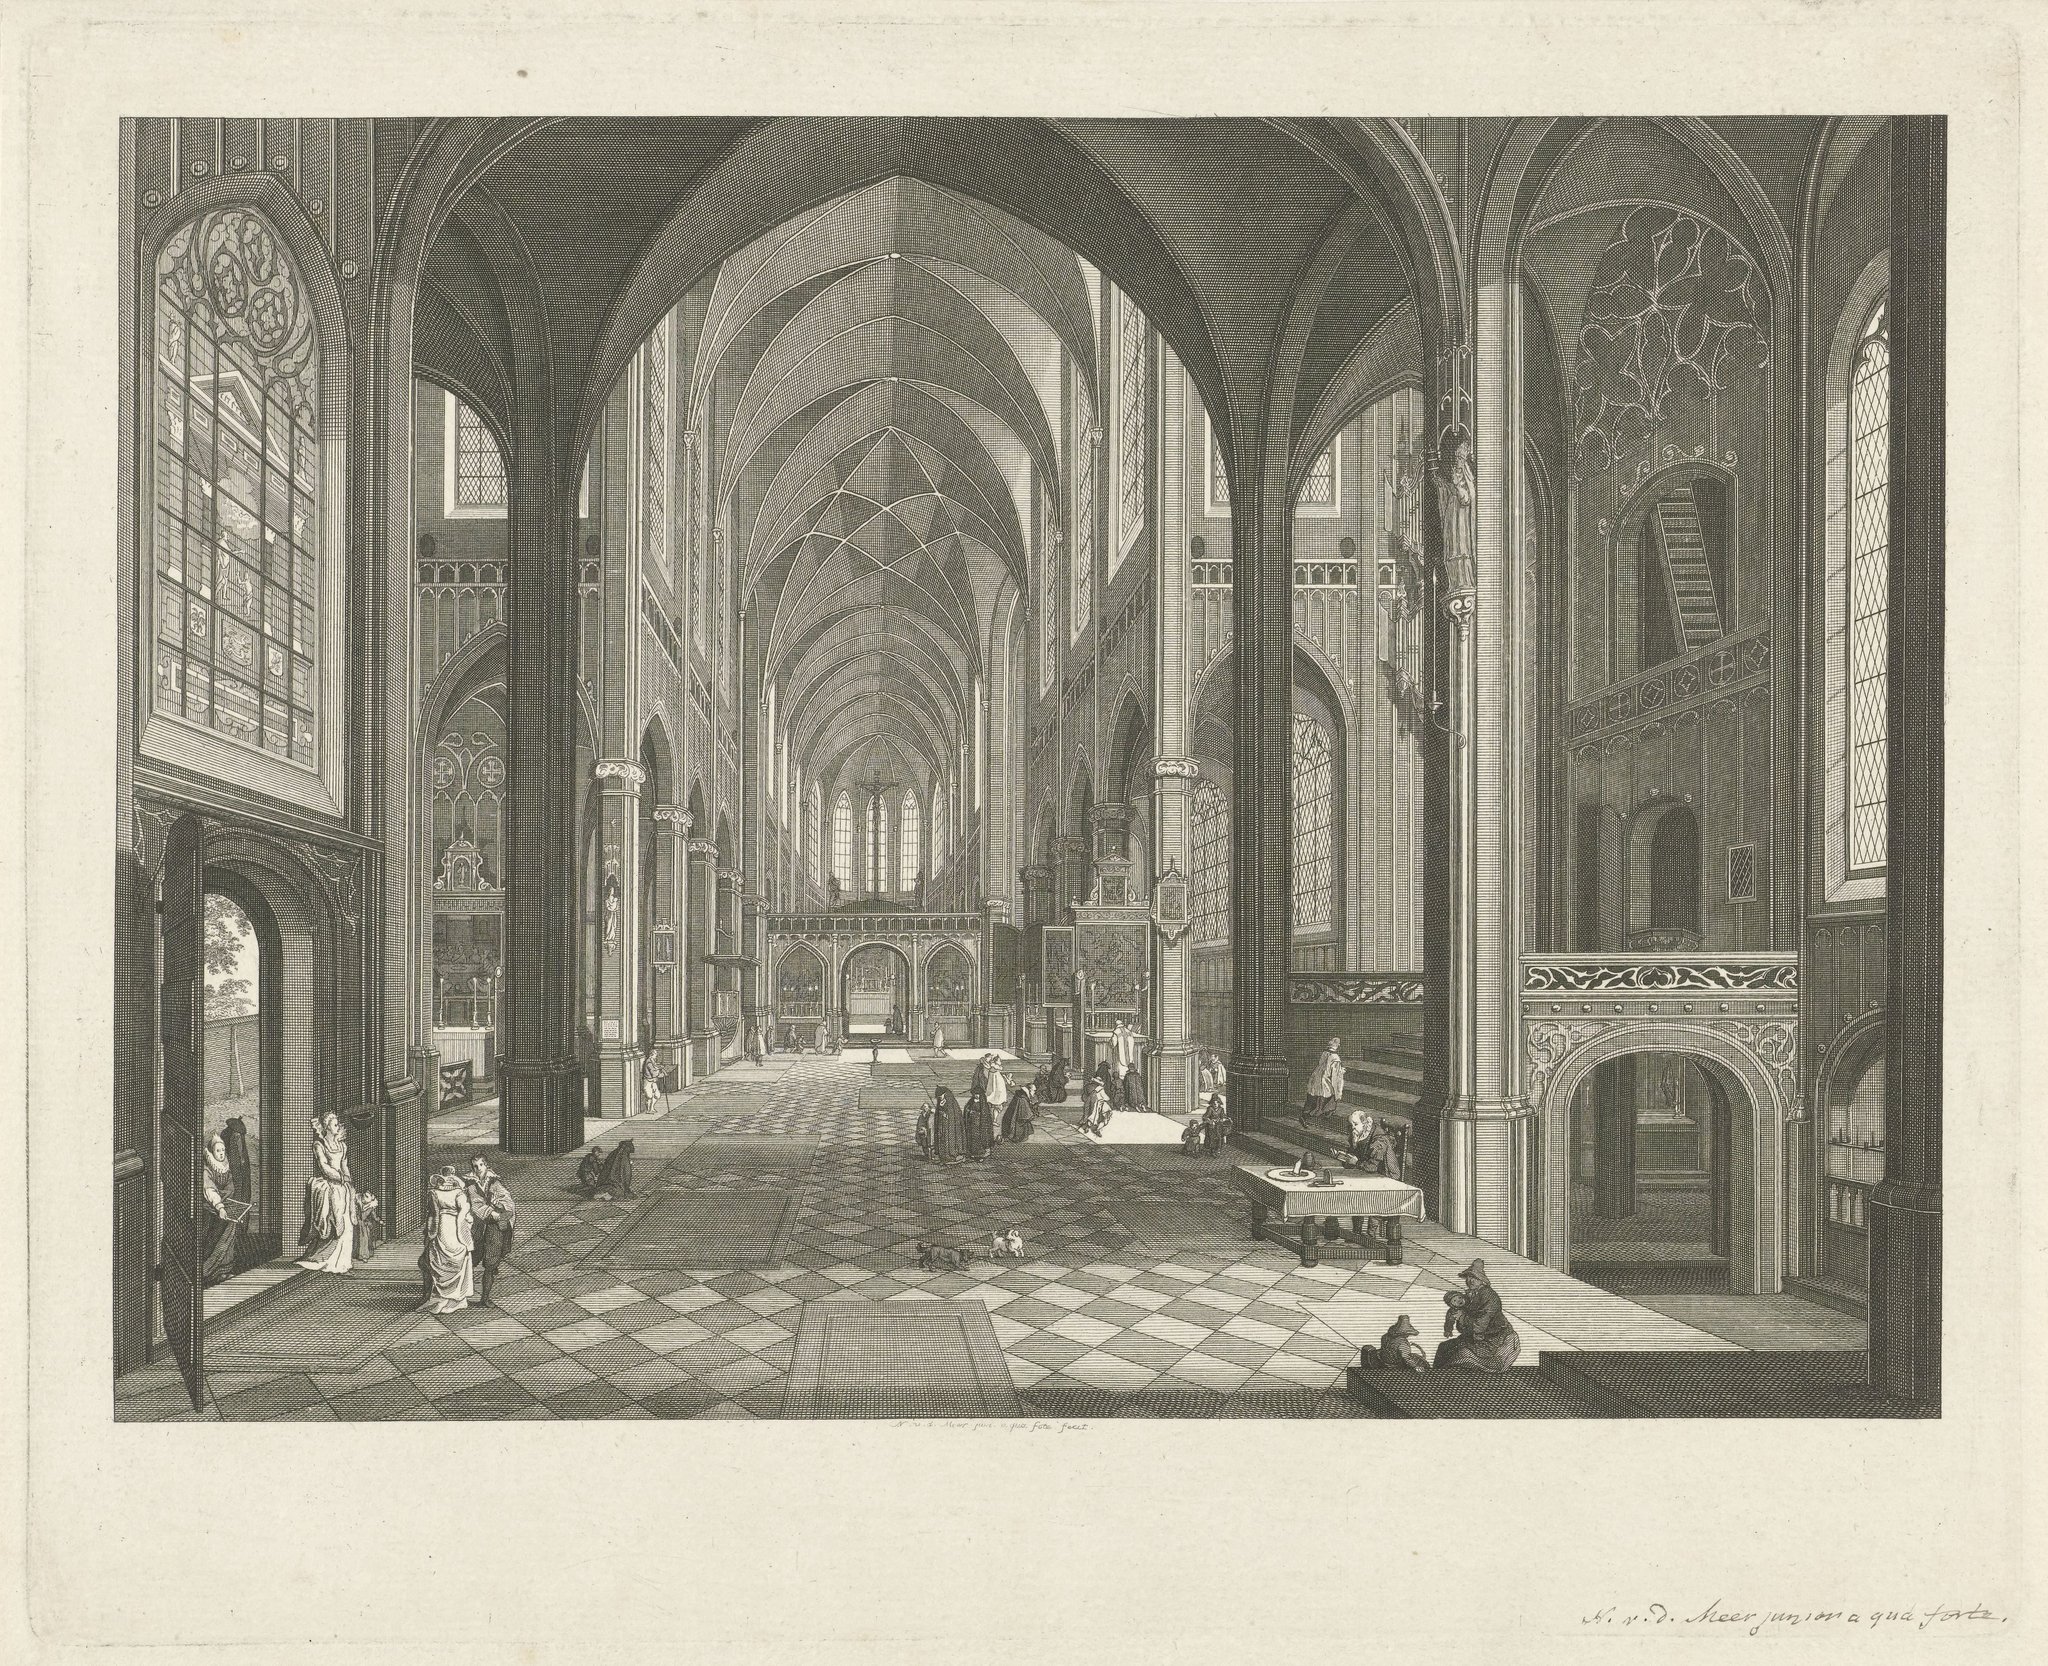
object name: print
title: Kerkinterieur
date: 1751-1822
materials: paper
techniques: engraving, etching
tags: interior of church, holy mass (divine service, especially of roman catholic church)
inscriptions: inscription: ‘N. v.d. Meer junior aqua forte’, collector's mark: Lugt 2228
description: Het interieur van een Rooms-katholieke kerk. Links betreden rijk geklede mensen de kerk. Rechts zit een man achter een tafel. Bij één van de zijaltaren draagt een priester de mis op.